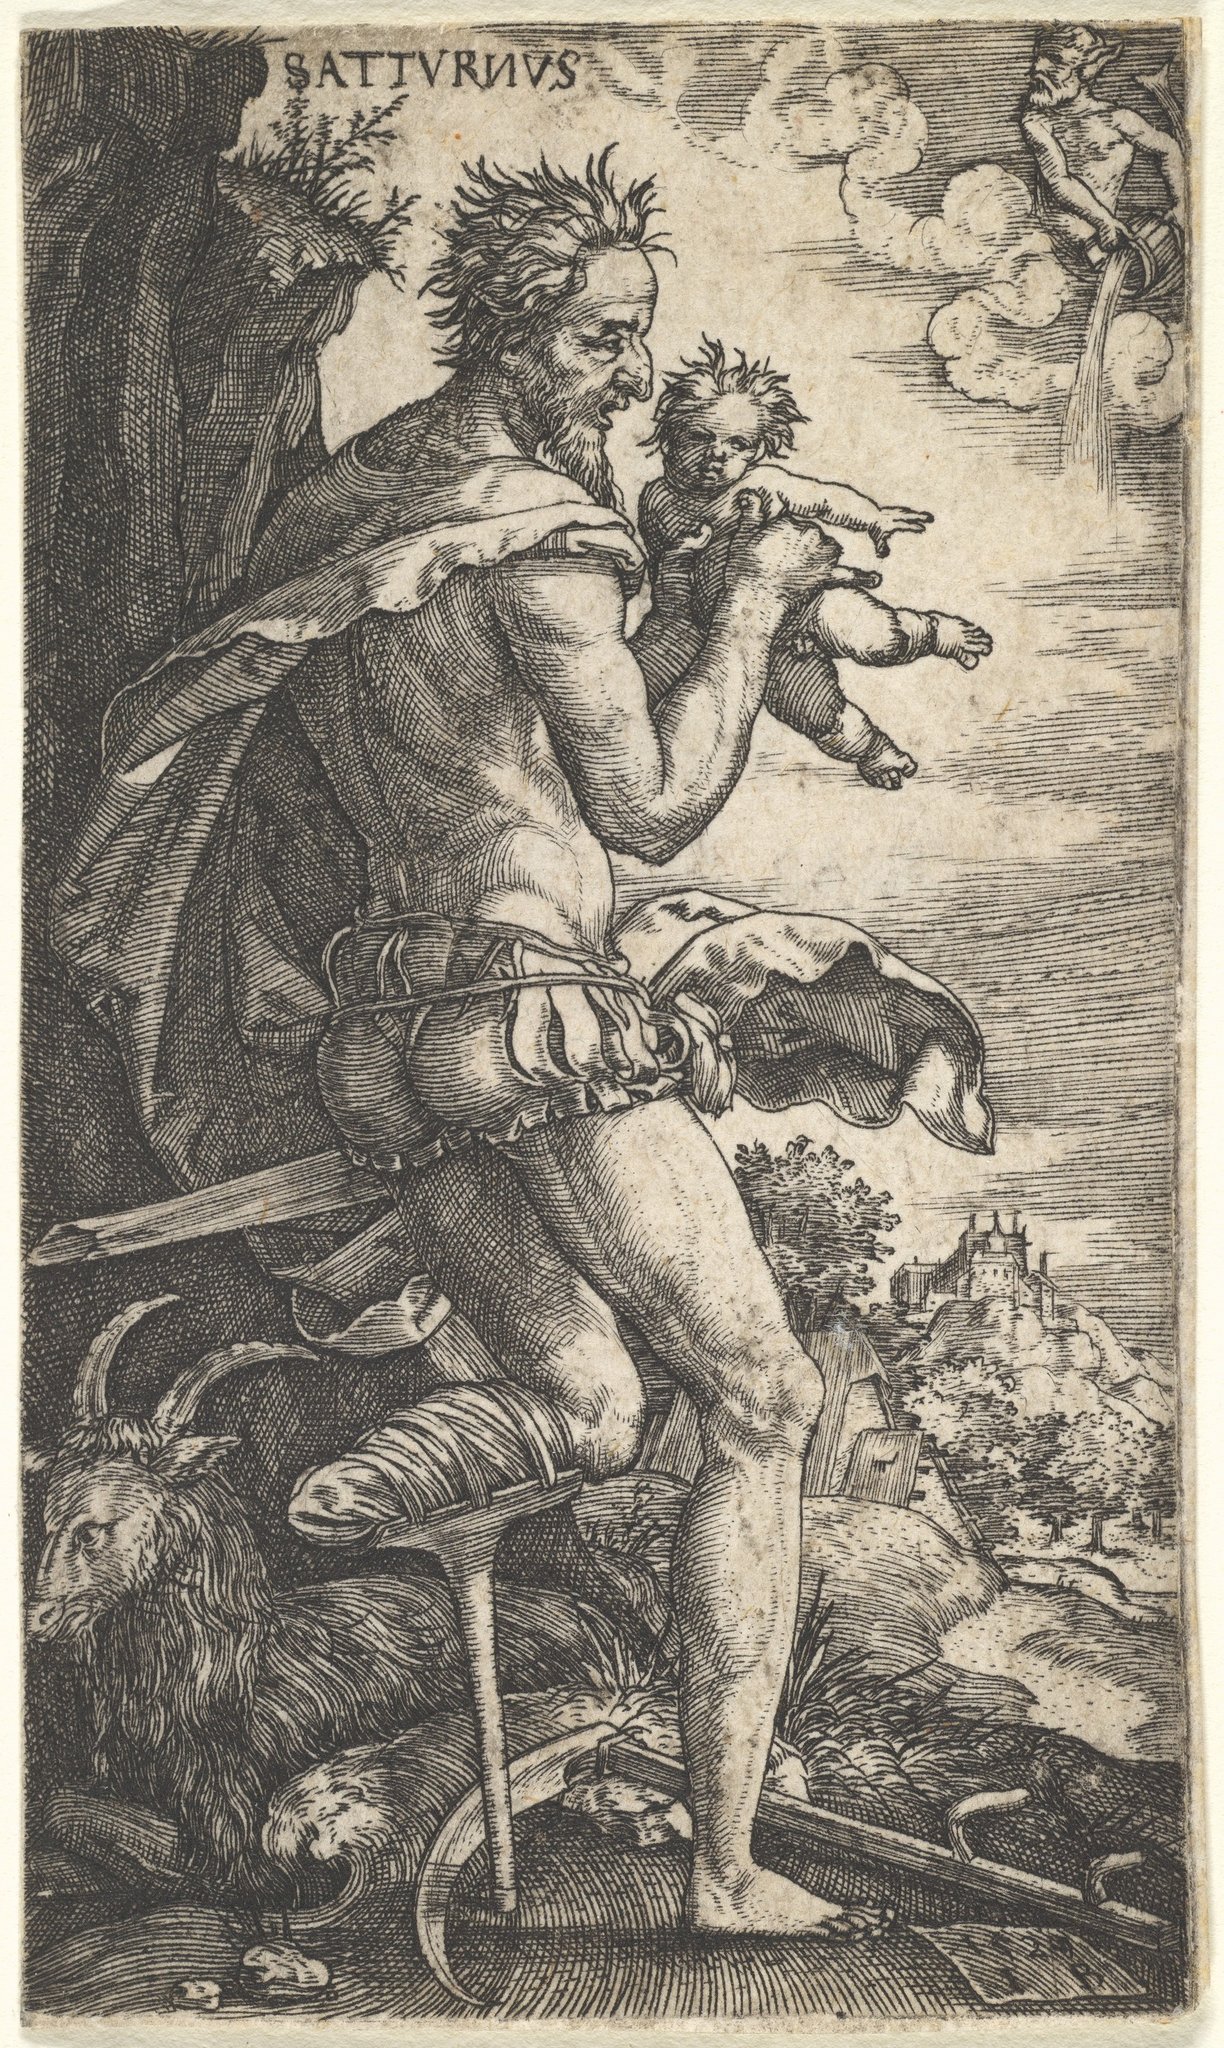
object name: print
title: Saturn, from "The Gods Who Preside Over the Planets"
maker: master i.b.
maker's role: artist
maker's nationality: german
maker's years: 1525-1530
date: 1525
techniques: etching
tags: infants,saturn